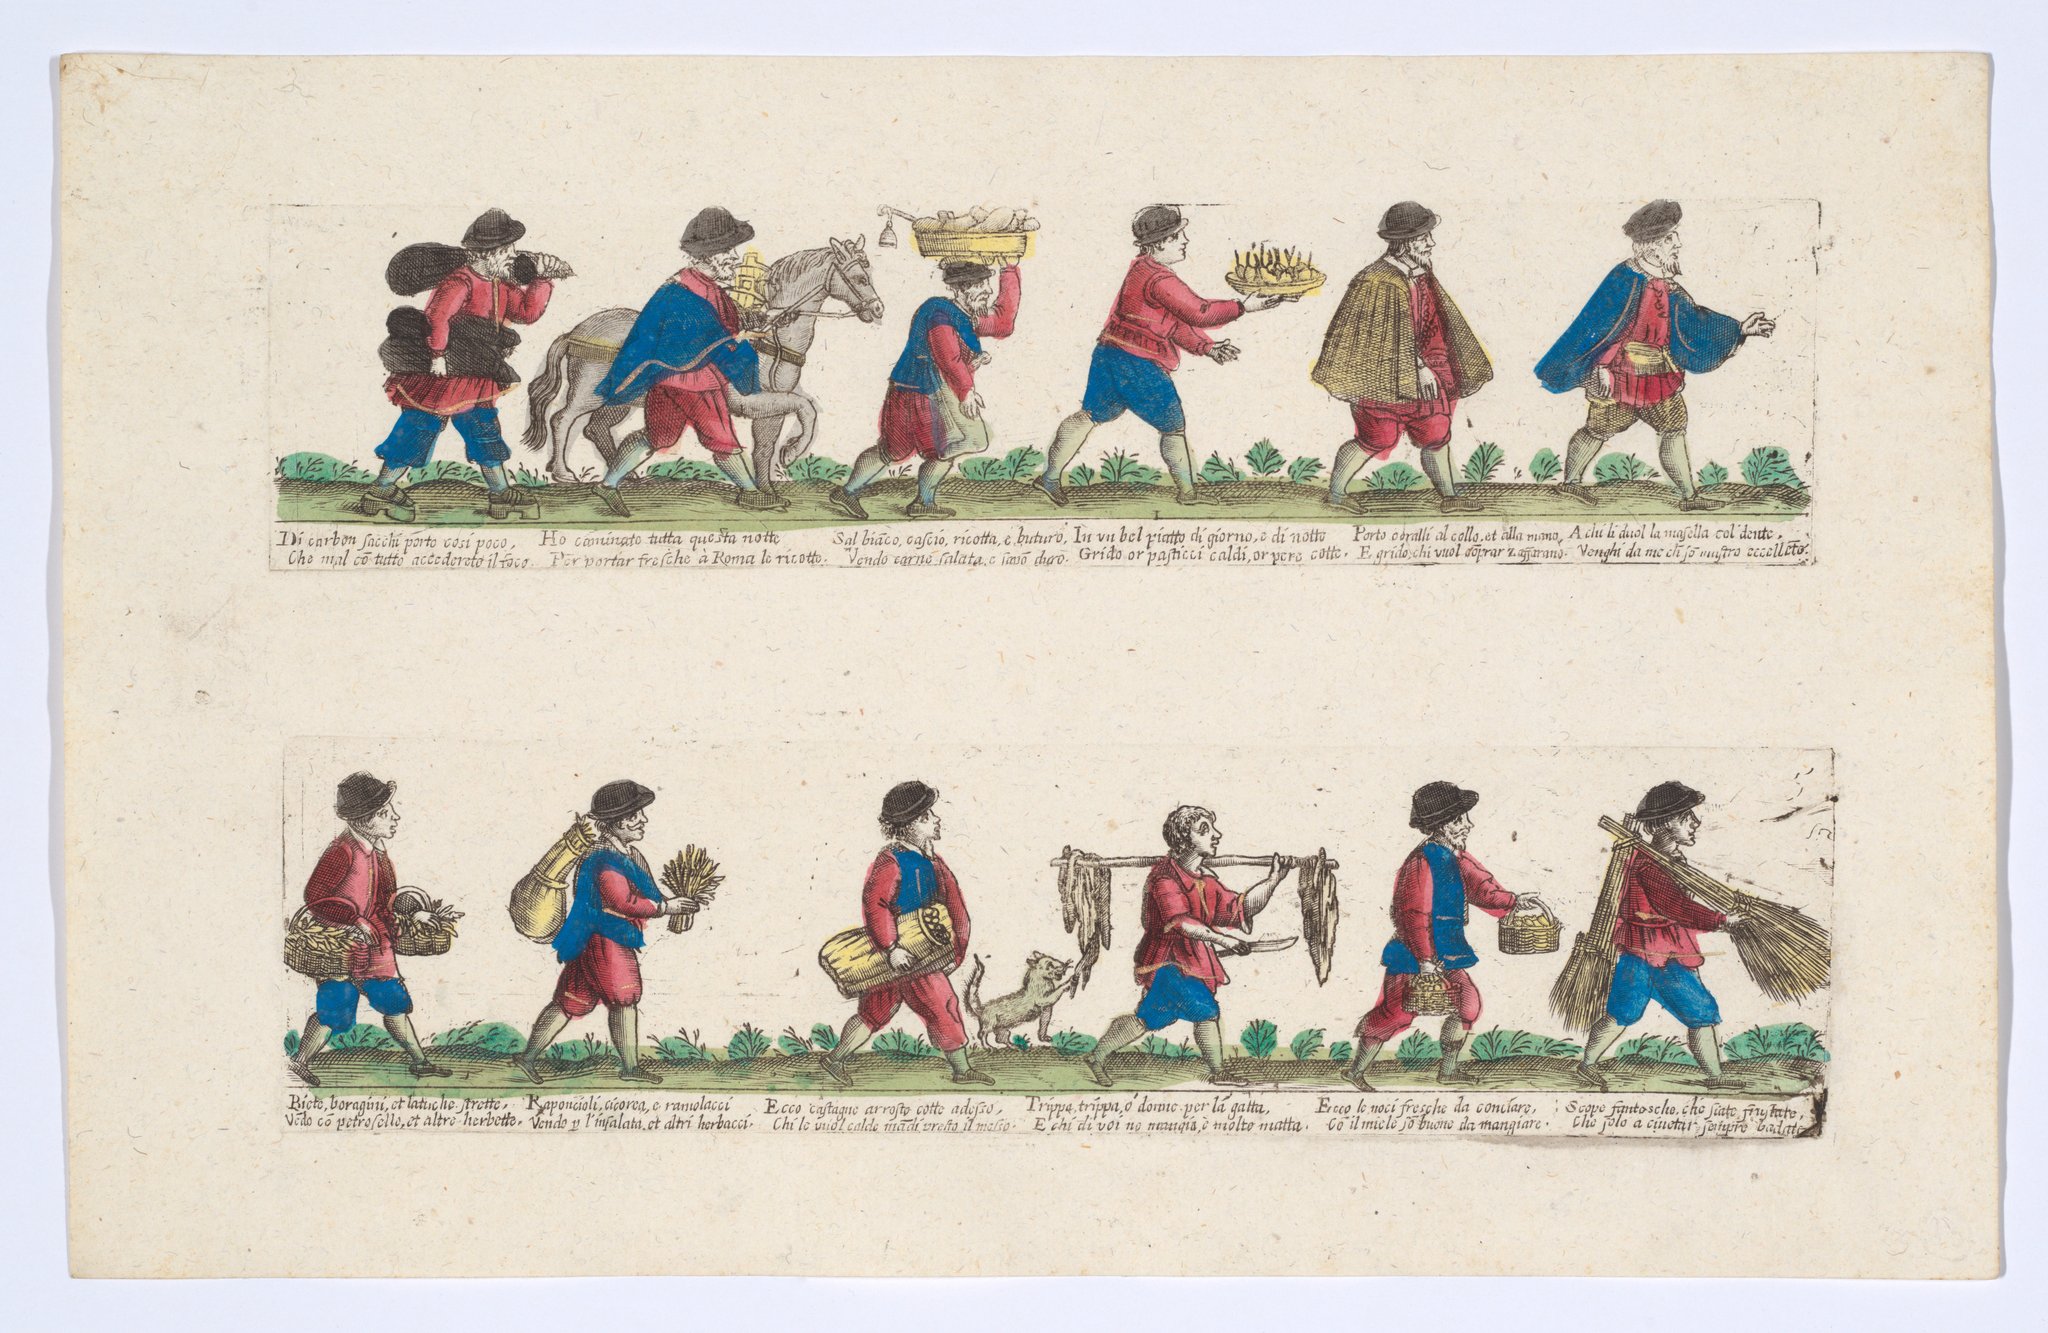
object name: print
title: Plate 5 (second group) depicting the trades of Rome, here including vendors of coal, cheese, tripe etc, from the 'Descrición de las artes que se llaman para los calles de la ciudad de Roma'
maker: remondini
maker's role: publisher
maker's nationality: italian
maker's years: 1650-1860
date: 1770-1800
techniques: engraving, hand coloring